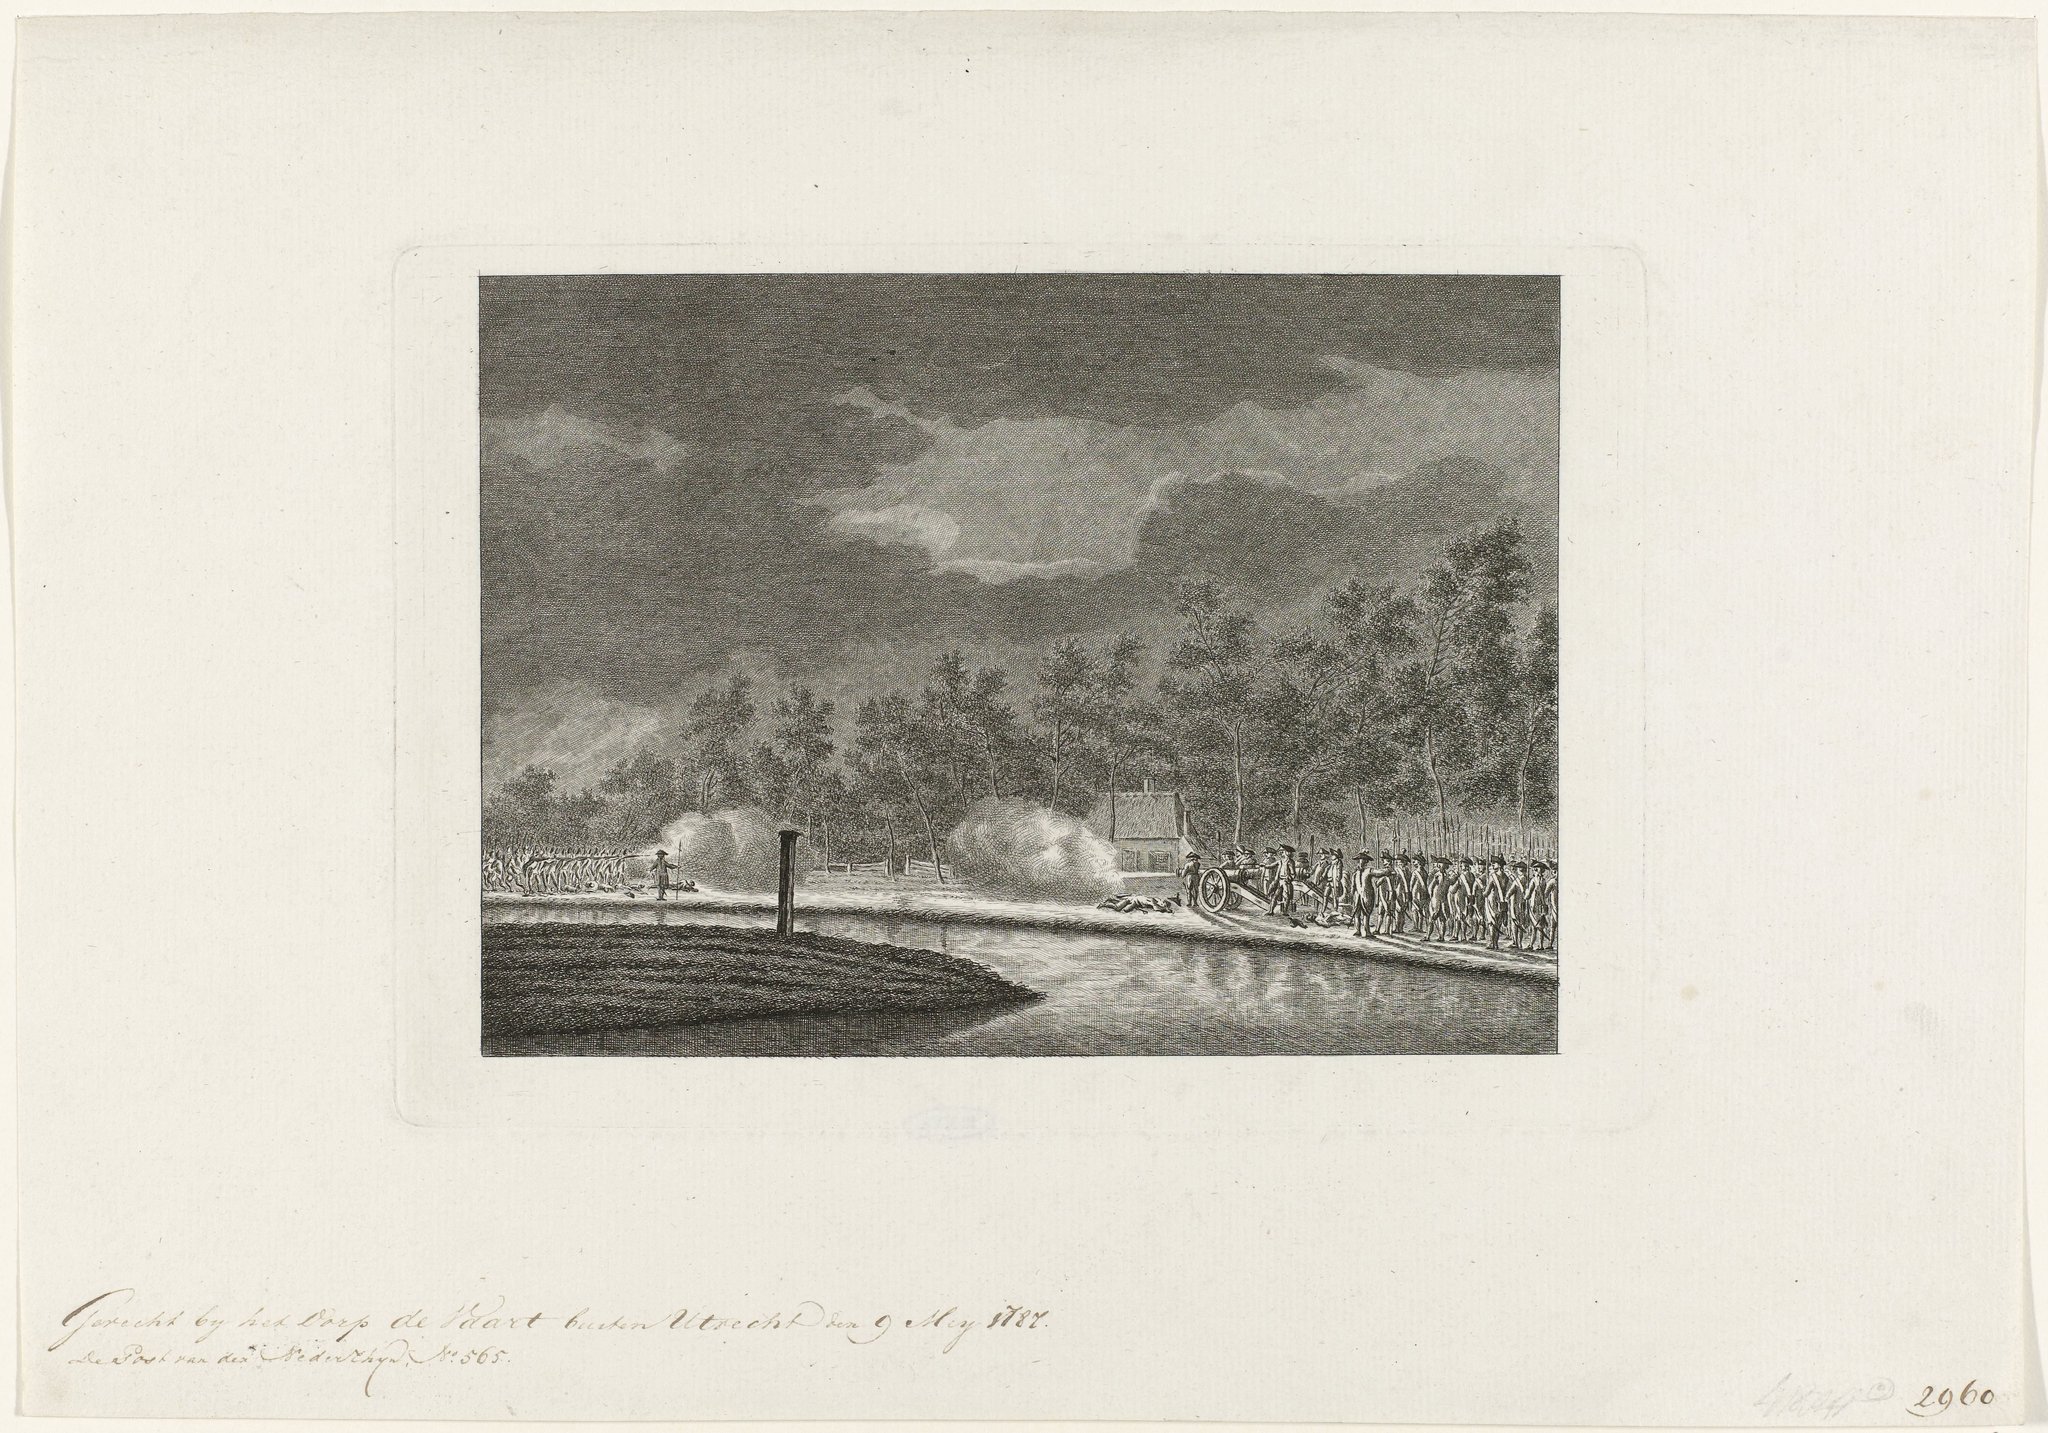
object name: print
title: Vuurgevecht bij Vreeswijk, 1787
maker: Anonymous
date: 1787-1792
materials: paper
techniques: engraving, etching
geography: northern netherlands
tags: battle (+ citizen soldiery, civil guard, citizen militia)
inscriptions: collector's mark: Lugt 2228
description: Vuurgevecht aan de vaart bij Vreeswijk buiten Utrecht tussen gewapende burgers van de Utrechtse schutterij en troepen van het regiment Van Efferen, in de avond van 9 mei 1787.